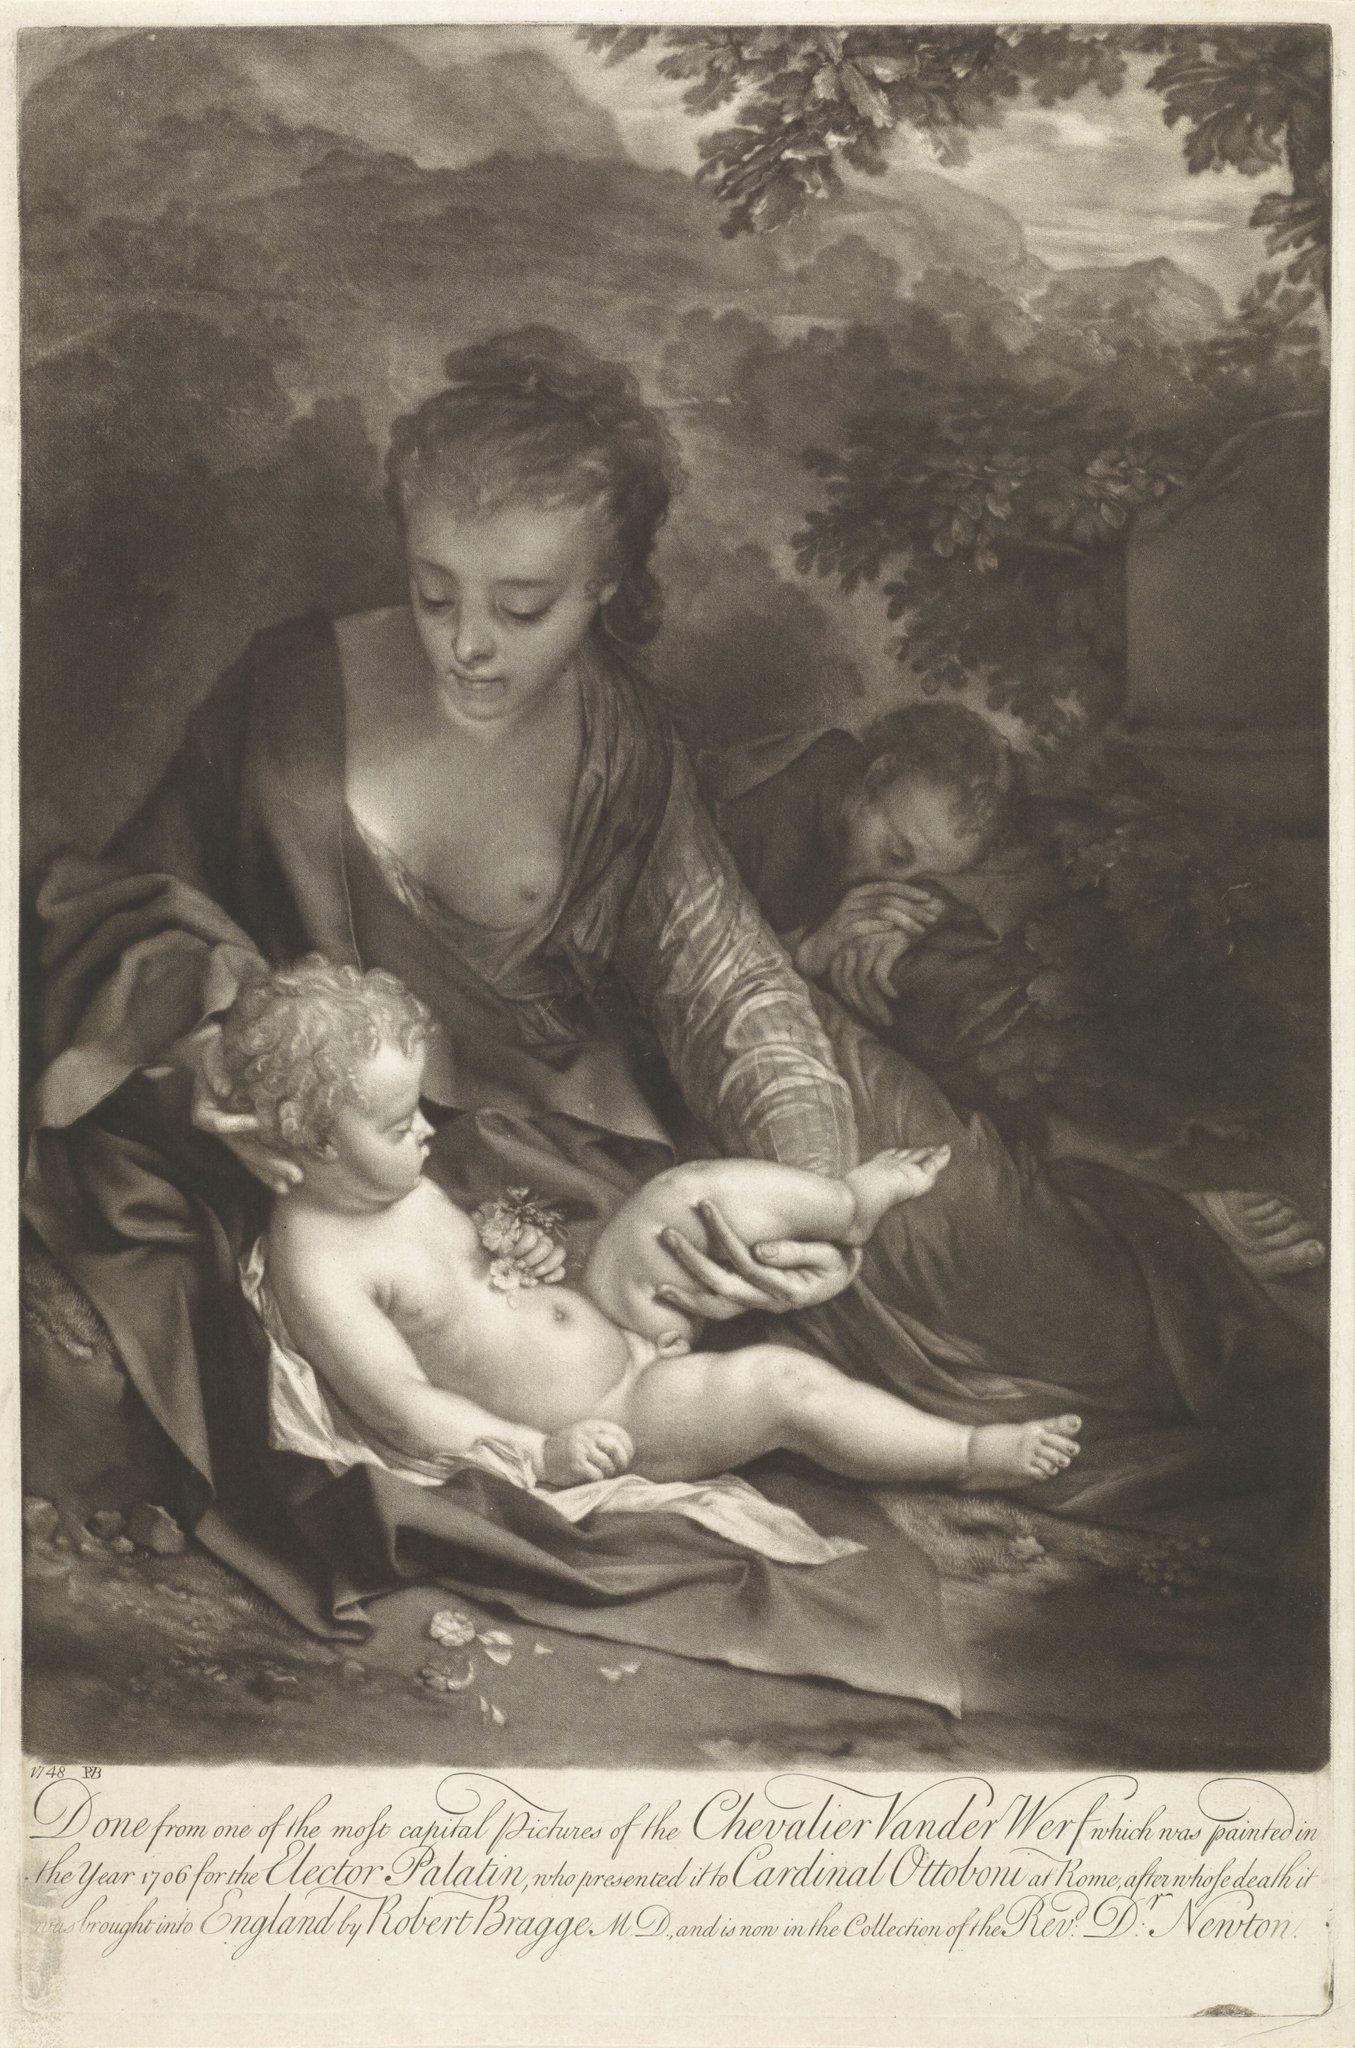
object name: print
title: Rest on the Flight into Egypt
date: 1748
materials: paper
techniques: engraving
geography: england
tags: rest on the flight into egypt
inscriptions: collector's mark: Lugt 240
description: De Heilige Familie rust in een landschap onder een boom. Maria legt het slapende Christuskind op een doek. Op de achtergrond zit Jozef te slapen.